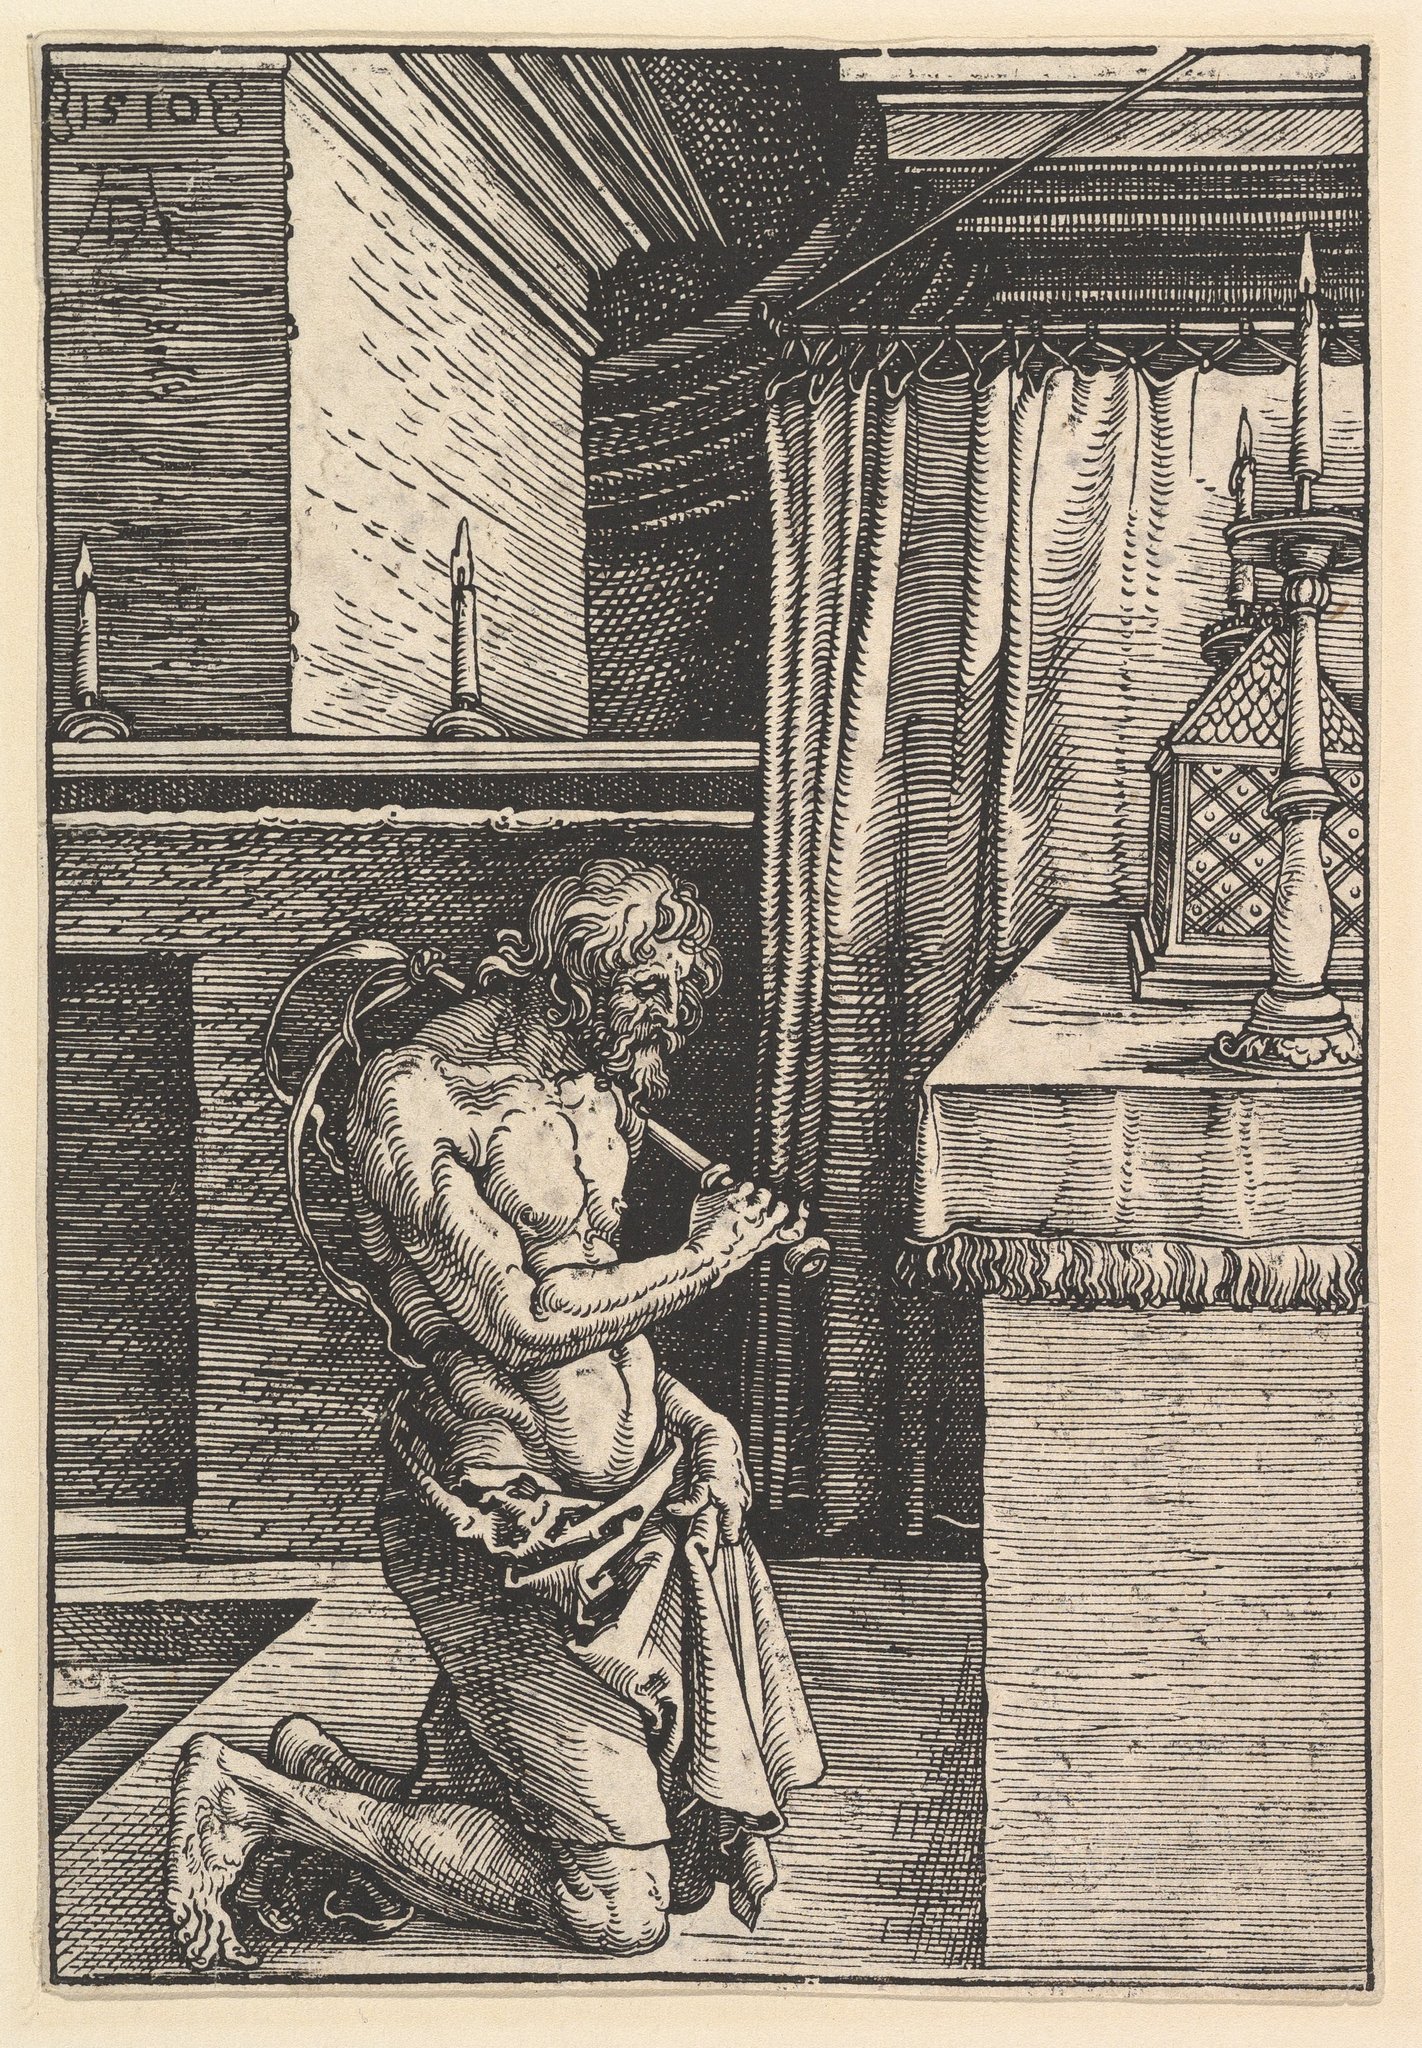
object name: print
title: The Penitent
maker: albrecht dürer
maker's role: artist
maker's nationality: german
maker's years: 1471-1528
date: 1510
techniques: woodcut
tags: men